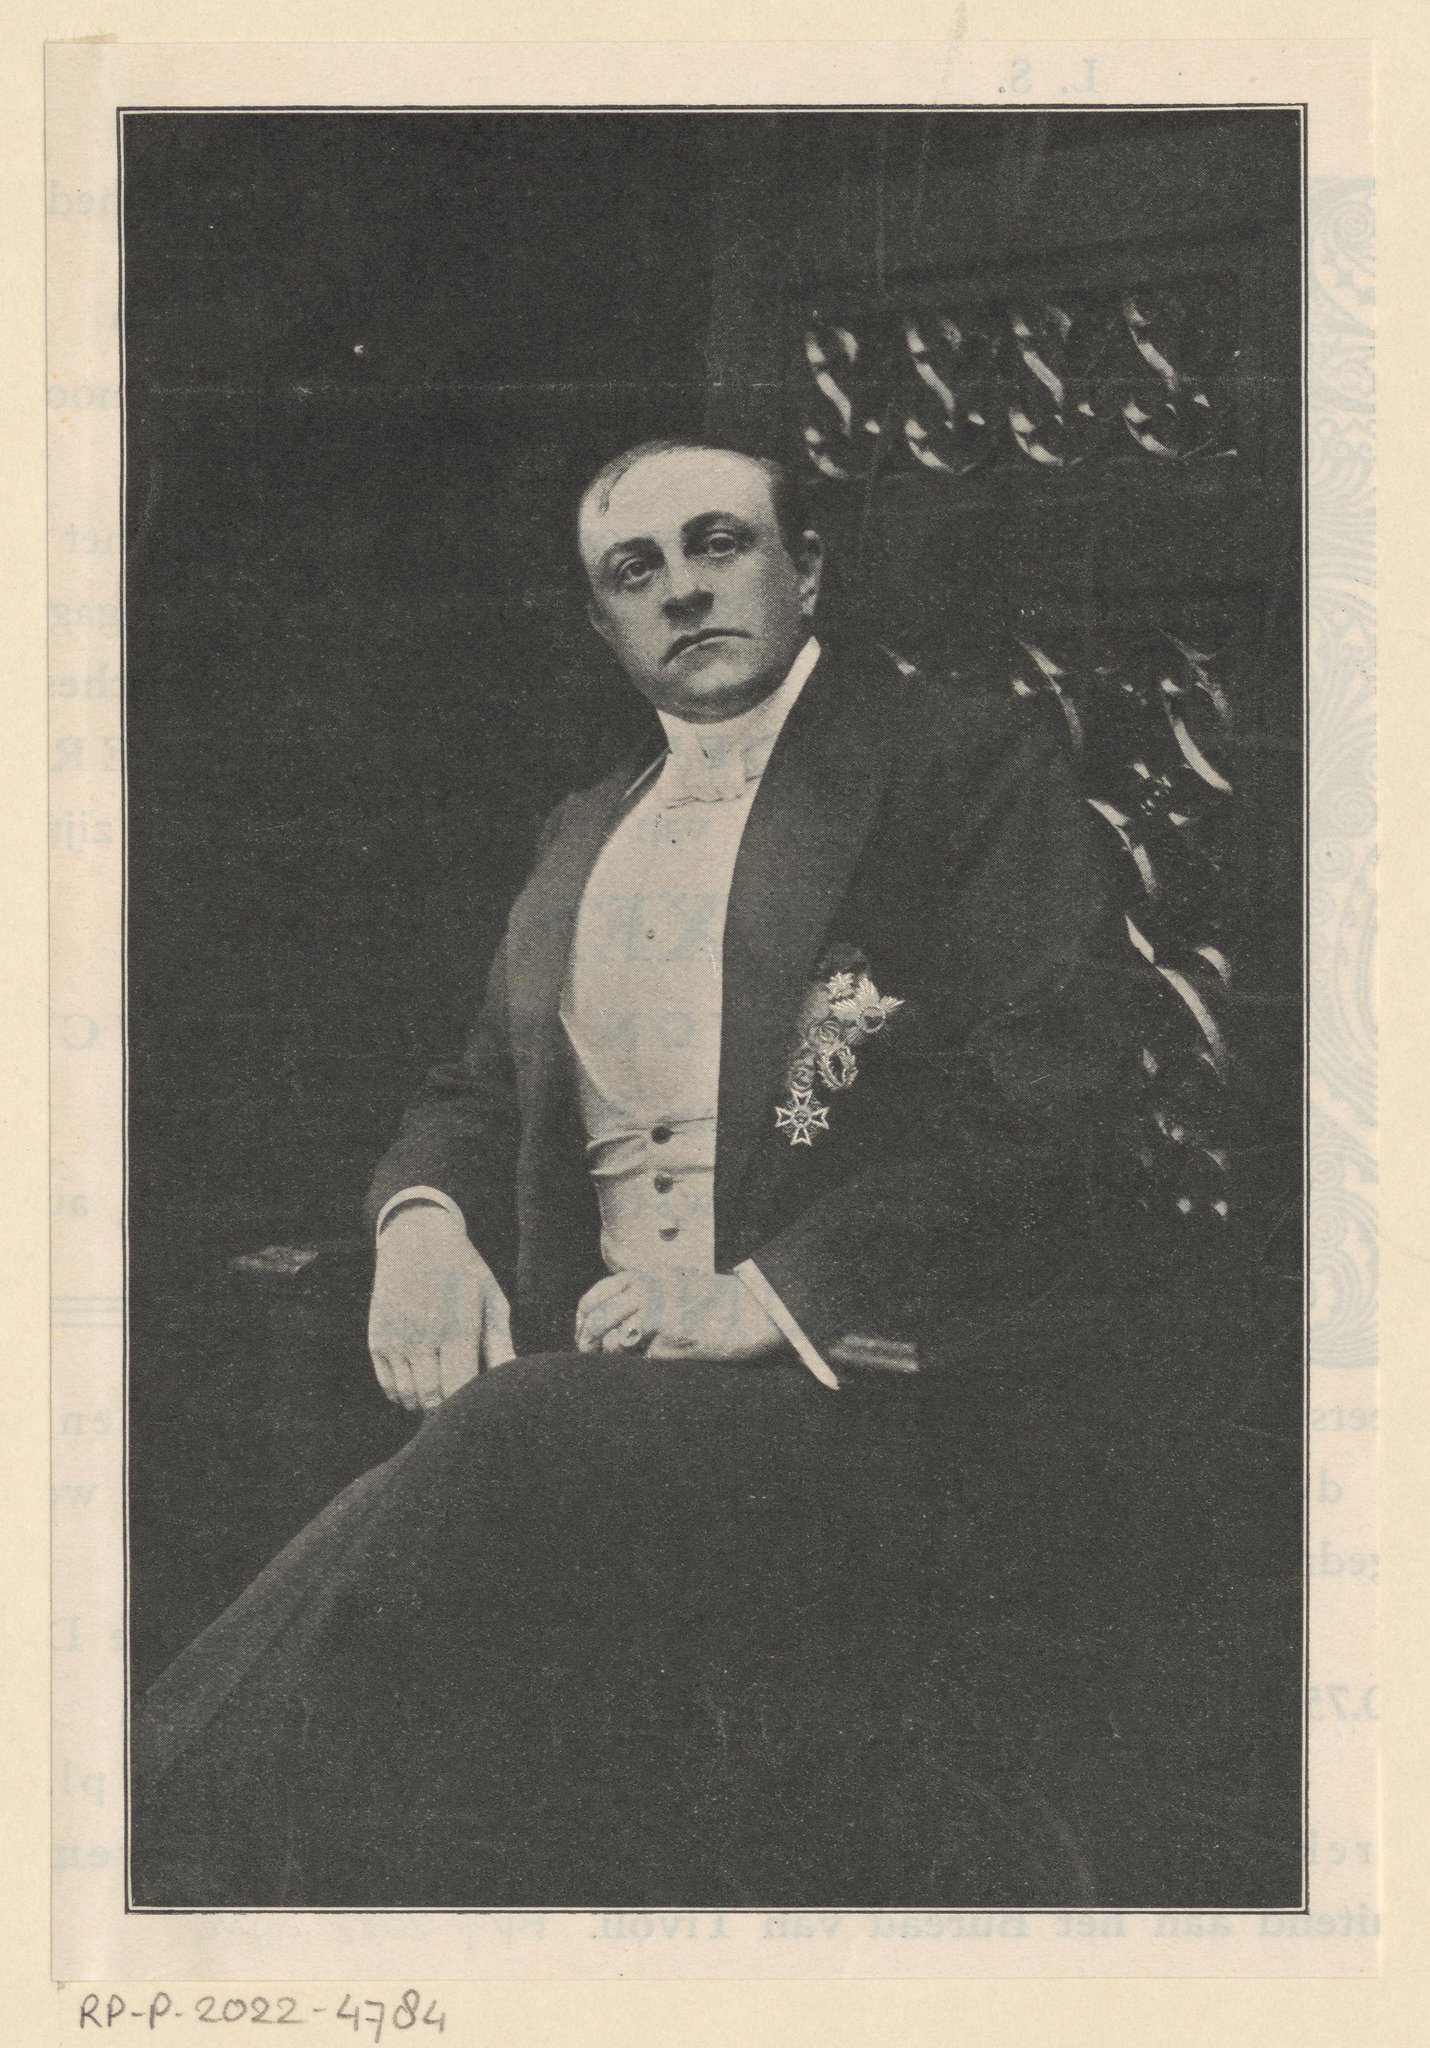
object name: photomechanical print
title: Portret van Albert Vogel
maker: Anonymous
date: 1909-1915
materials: paper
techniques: letterpress printing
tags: bergen op zoom, the hague, historical persons, writer, poet, author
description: Fotomechanische afdruk komt uit een onbekende publicatie.